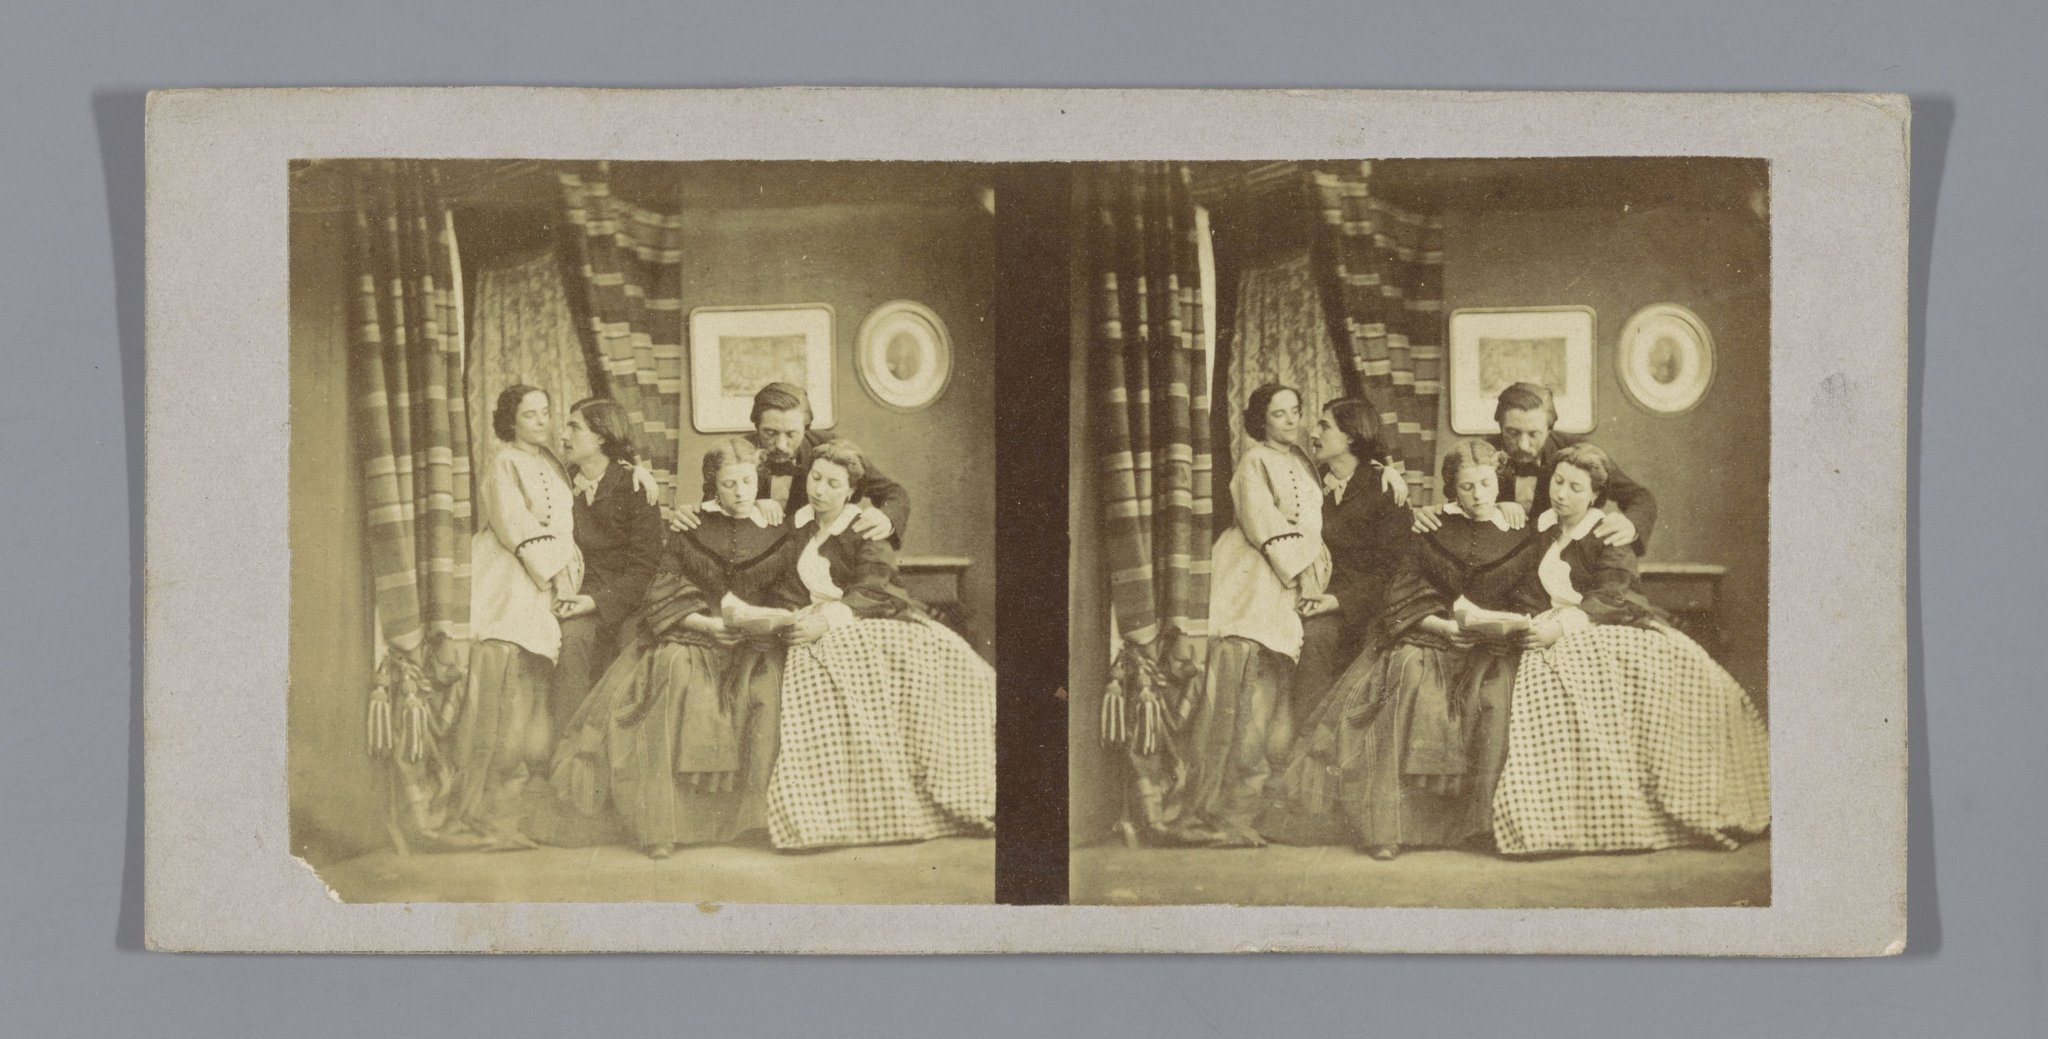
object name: stereograph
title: Man met twee meisjes op de voorgrond, op de achtergrond een verliefd paar tussen gordijnen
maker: Anonymous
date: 1850-1880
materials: cardboard, photographic support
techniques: albumen print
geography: europe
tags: curtains, couple of lovers, europe